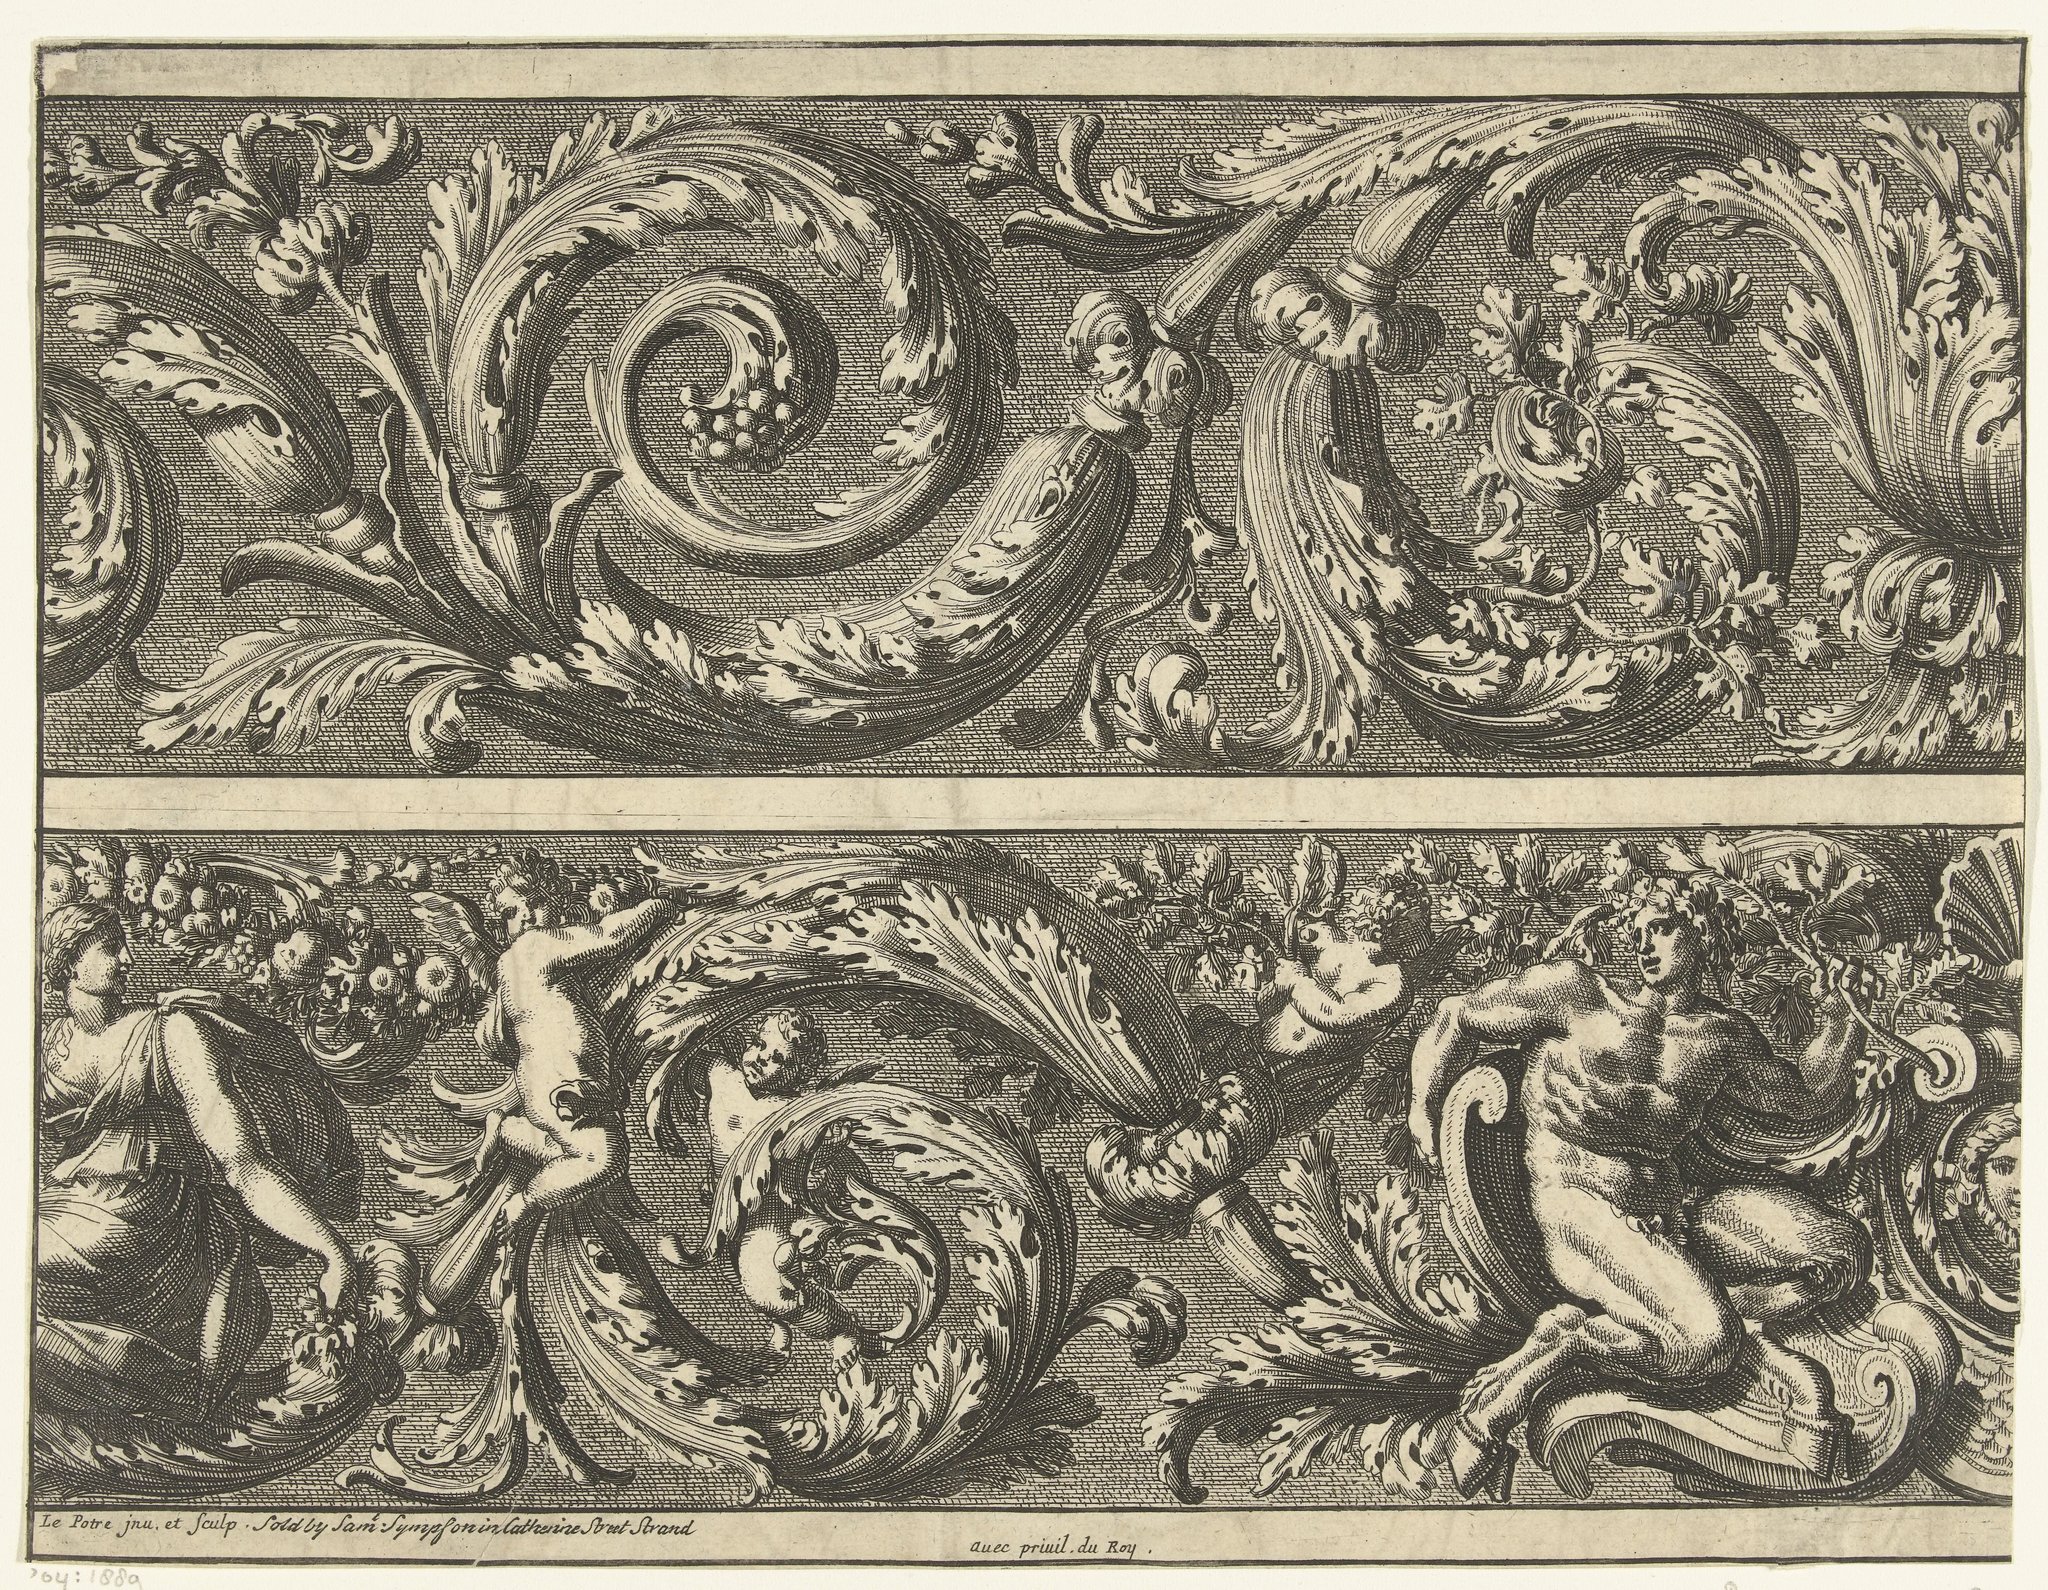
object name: ornament print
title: Twee friezen met bladranken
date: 1731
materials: paper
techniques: etching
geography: london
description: Het bovenste fries zonder en het onderste met figuren. Rechtsonder zit een sater die naar links kijkt. Blad uit serie van 6, derde editie.